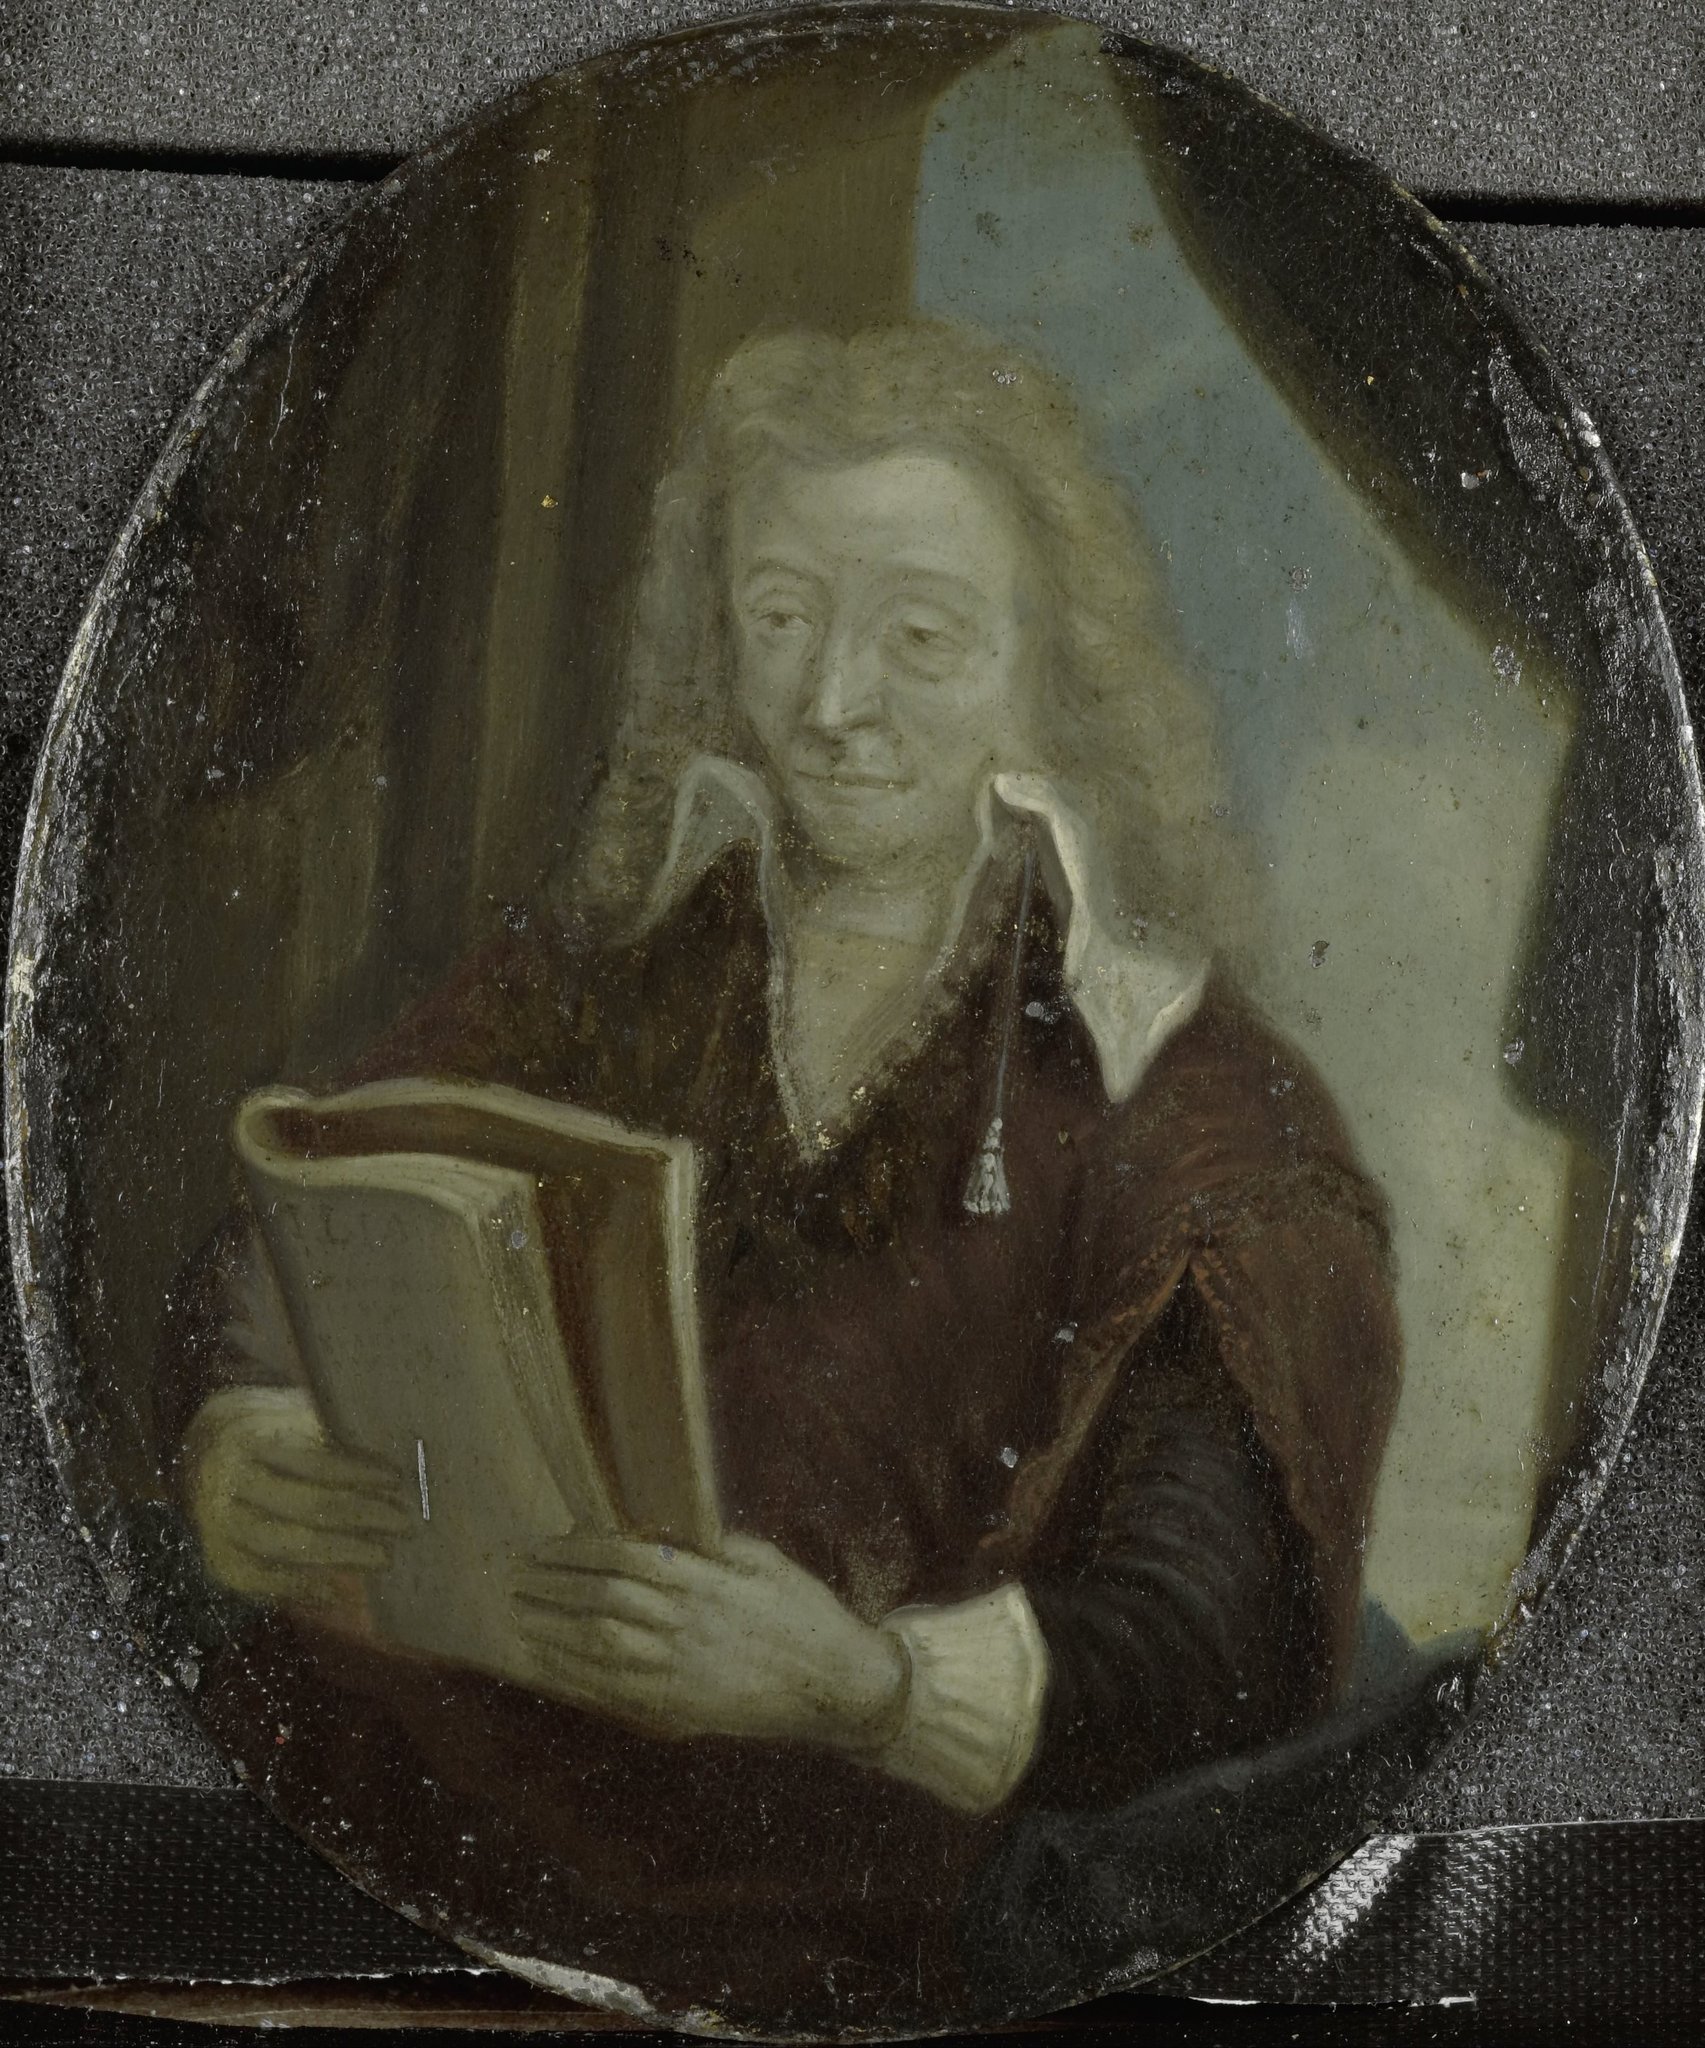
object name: painting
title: Portrait of Jan Six, Poet and Burgomaster of Amsterdam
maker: arnoud van halen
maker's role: draughtsman, painter, print maker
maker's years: 1673-1732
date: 1700-1732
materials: oil, metal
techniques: grisaille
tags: amsterdam, mayor, jan six (1618-1700), portrait of a writer, writer, poet, author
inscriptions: inscription: ‘Jan Six. Burgermeester. 1618’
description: Portret van Jan Six (1618-1700). Dichter en burgemeester van Amsterdam. Buste in ovaal, aanziend. Staande voor een raam, lezend in een opengeslagen boek in de hand. Onderdeel van een verzameling portretten van Nederlandse dichters.